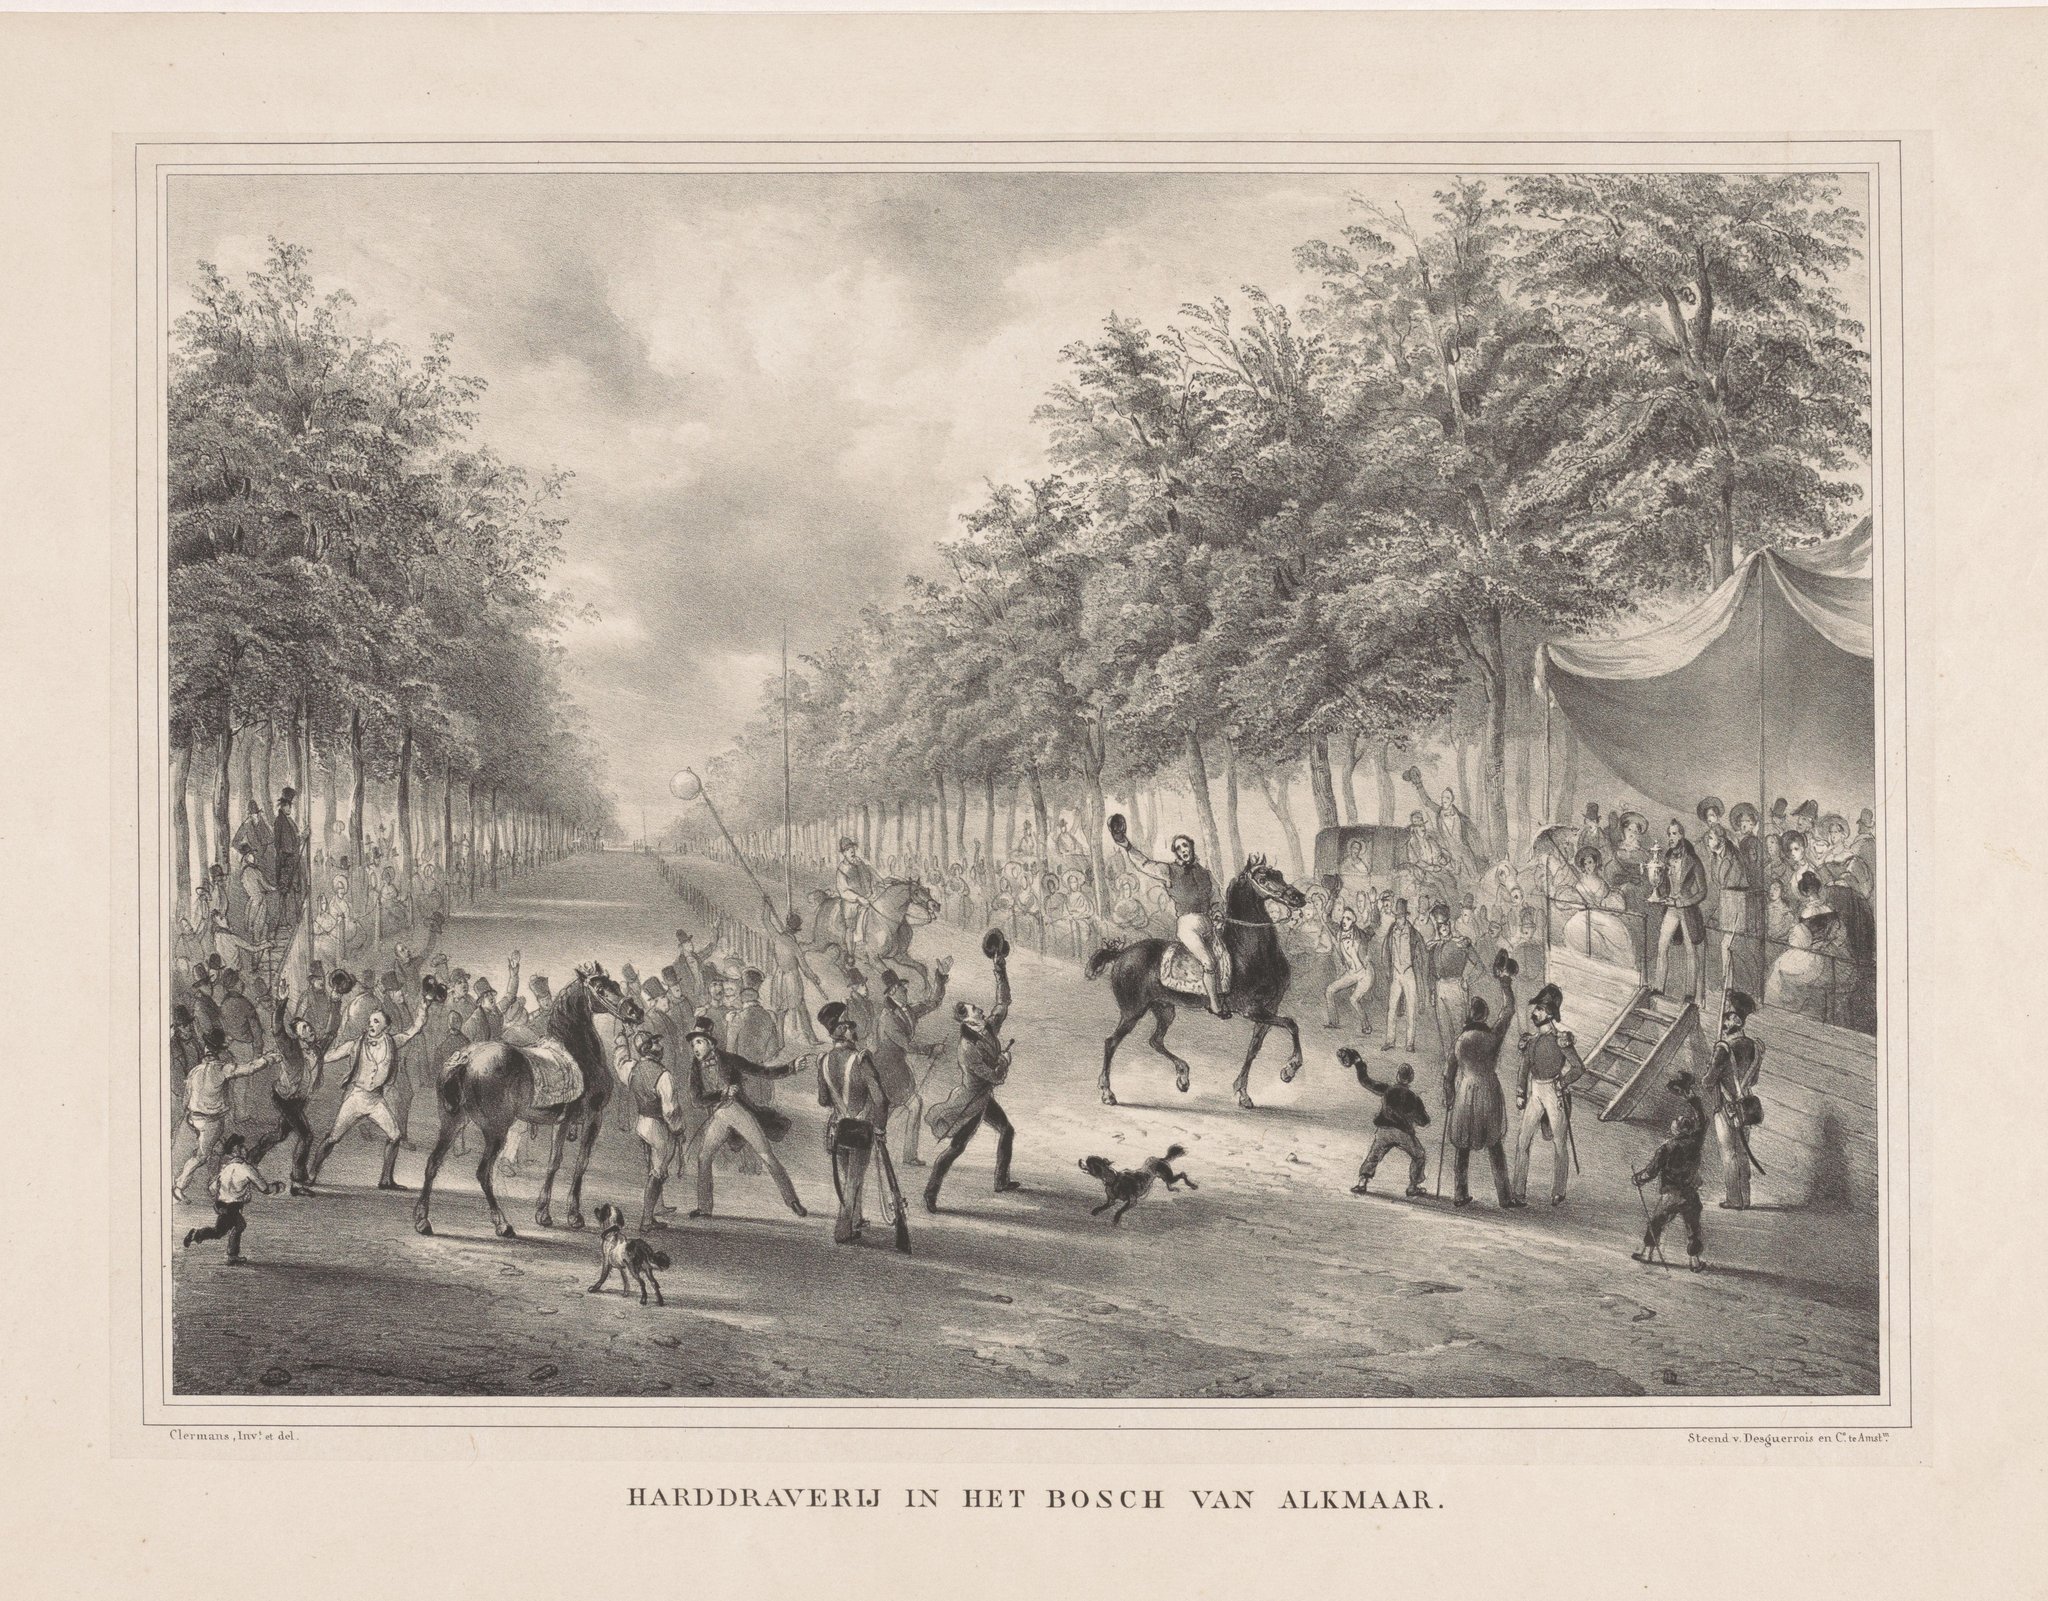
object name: print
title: Harddraverij in het bos van Alkmaar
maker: j.b. clermans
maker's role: print maker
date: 1826-1839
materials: paper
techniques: lithograph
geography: amsterdam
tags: horse-racing, forest path or lane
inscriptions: collector's mark: Lugt 2228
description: Te midden van rijen bomen ligt een renbaan met daarop twee ruiters te paard. Een van hen, net over de finish gekomen, heeft zijn cap afgenomen en zwaait ermee in de lucht. Links en rechts van de baan staan toeschouwers. Rechts een tent met daarin dames uit de gegoede burgerij. Een man staat bovenaan de trap met in zijn handen de beker voor de winnaar.